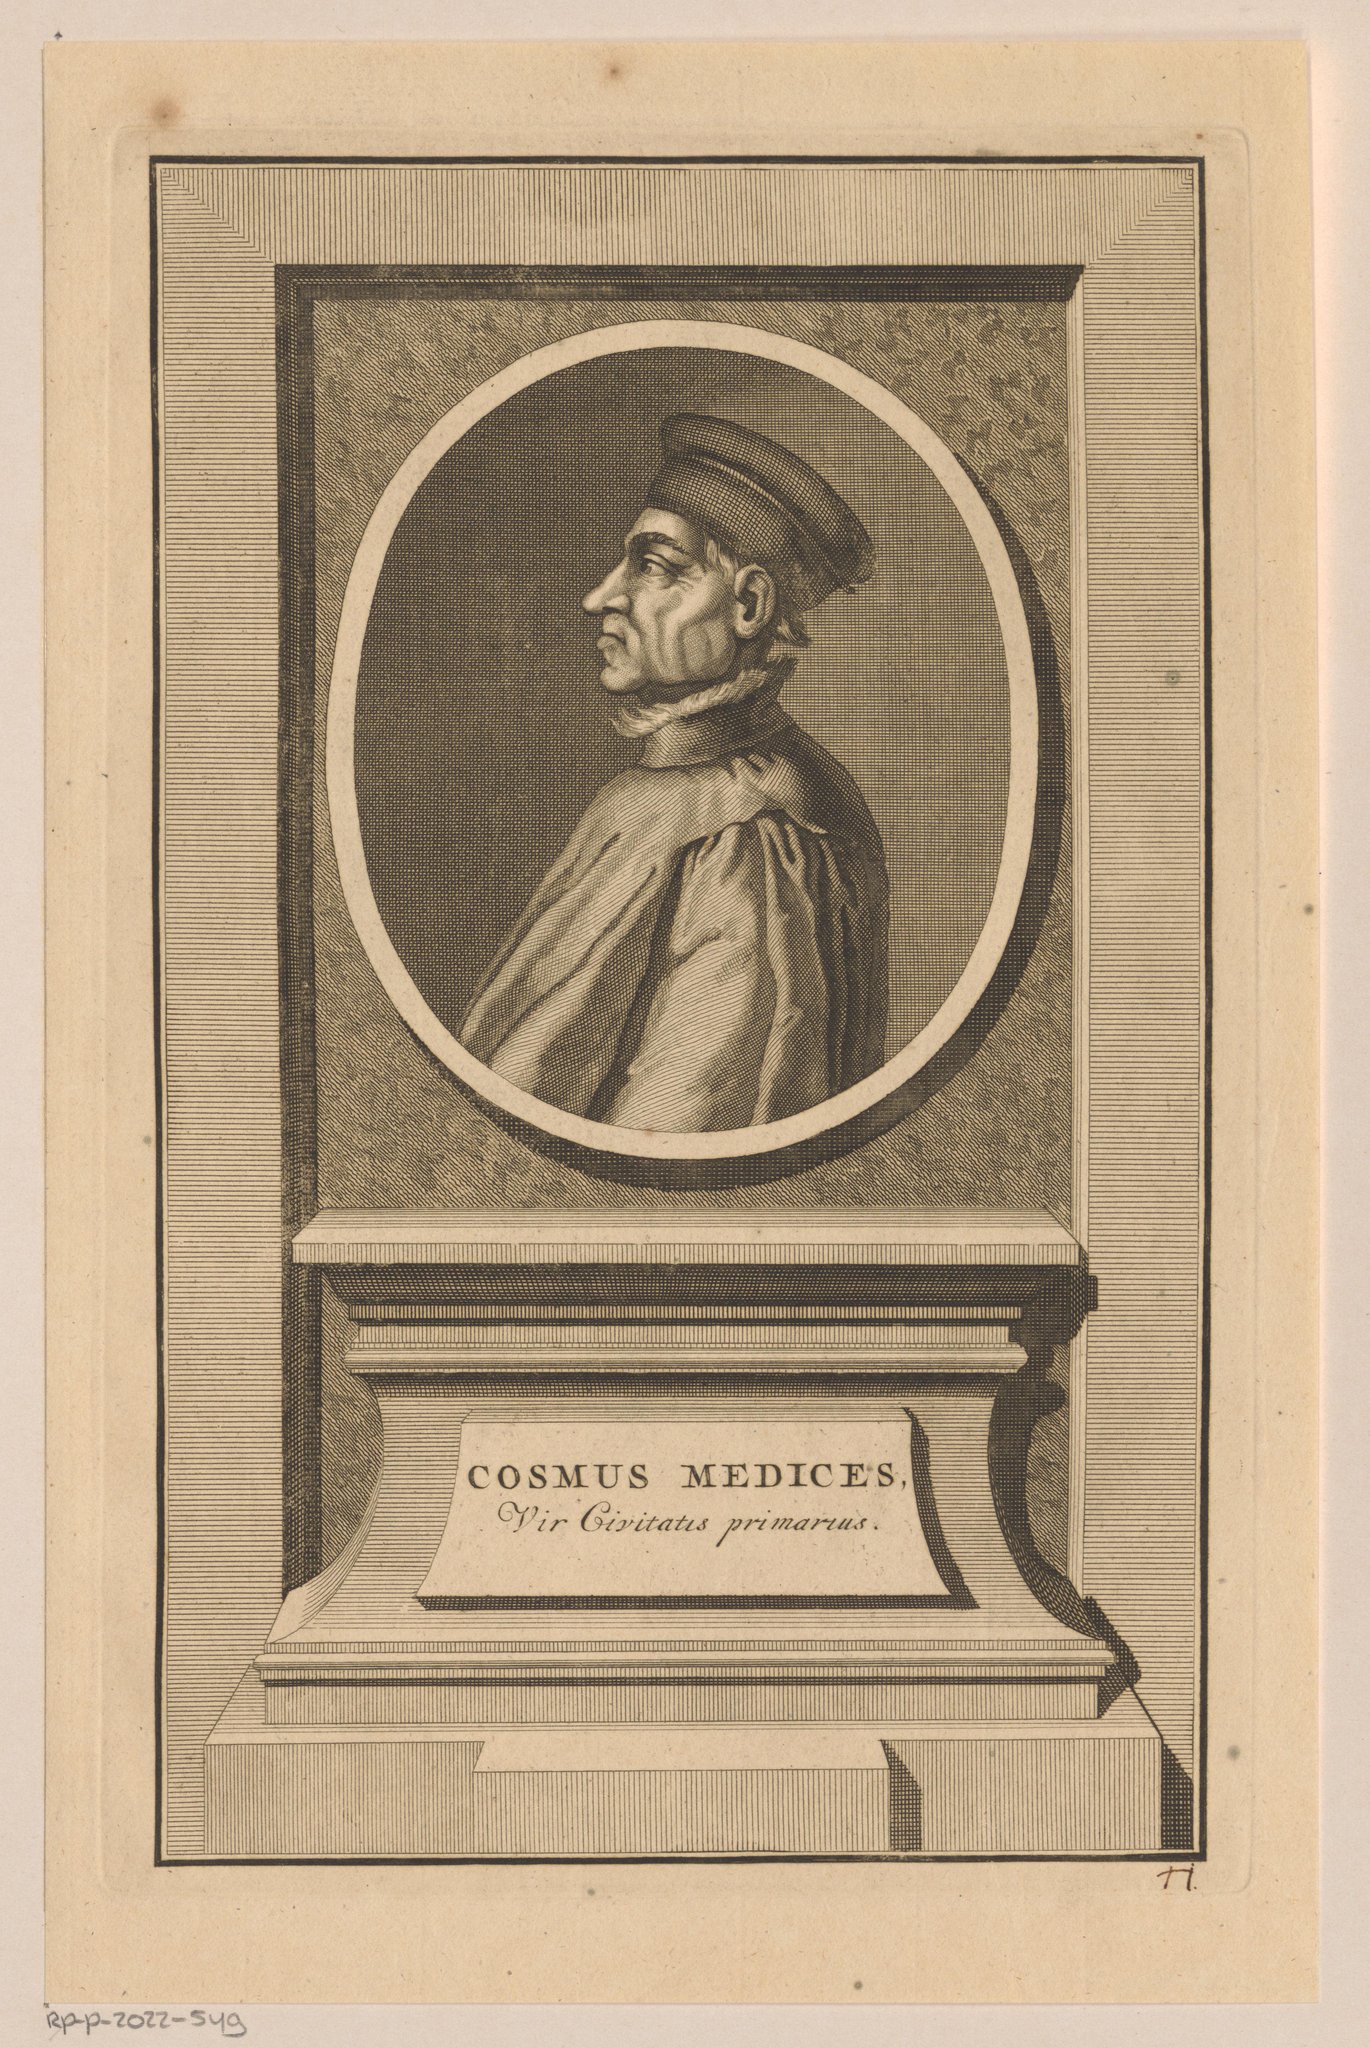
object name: print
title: Cabinet de XLI portraits des grands ducs, electeurs, archiducs, & autres princes & princesses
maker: Anonymous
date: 1715-1730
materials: paper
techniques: etching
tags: cosimo i de' medici, historical persons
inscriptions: inscription: ‘T1.’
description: Prent waarschijnlijk uit: Cabinet de XLI. portraits des grands ducs, electeurs, archiducs, & autres princes & princesses. Leiden: Pieter van der Aa I, [ca. 1715-1730].